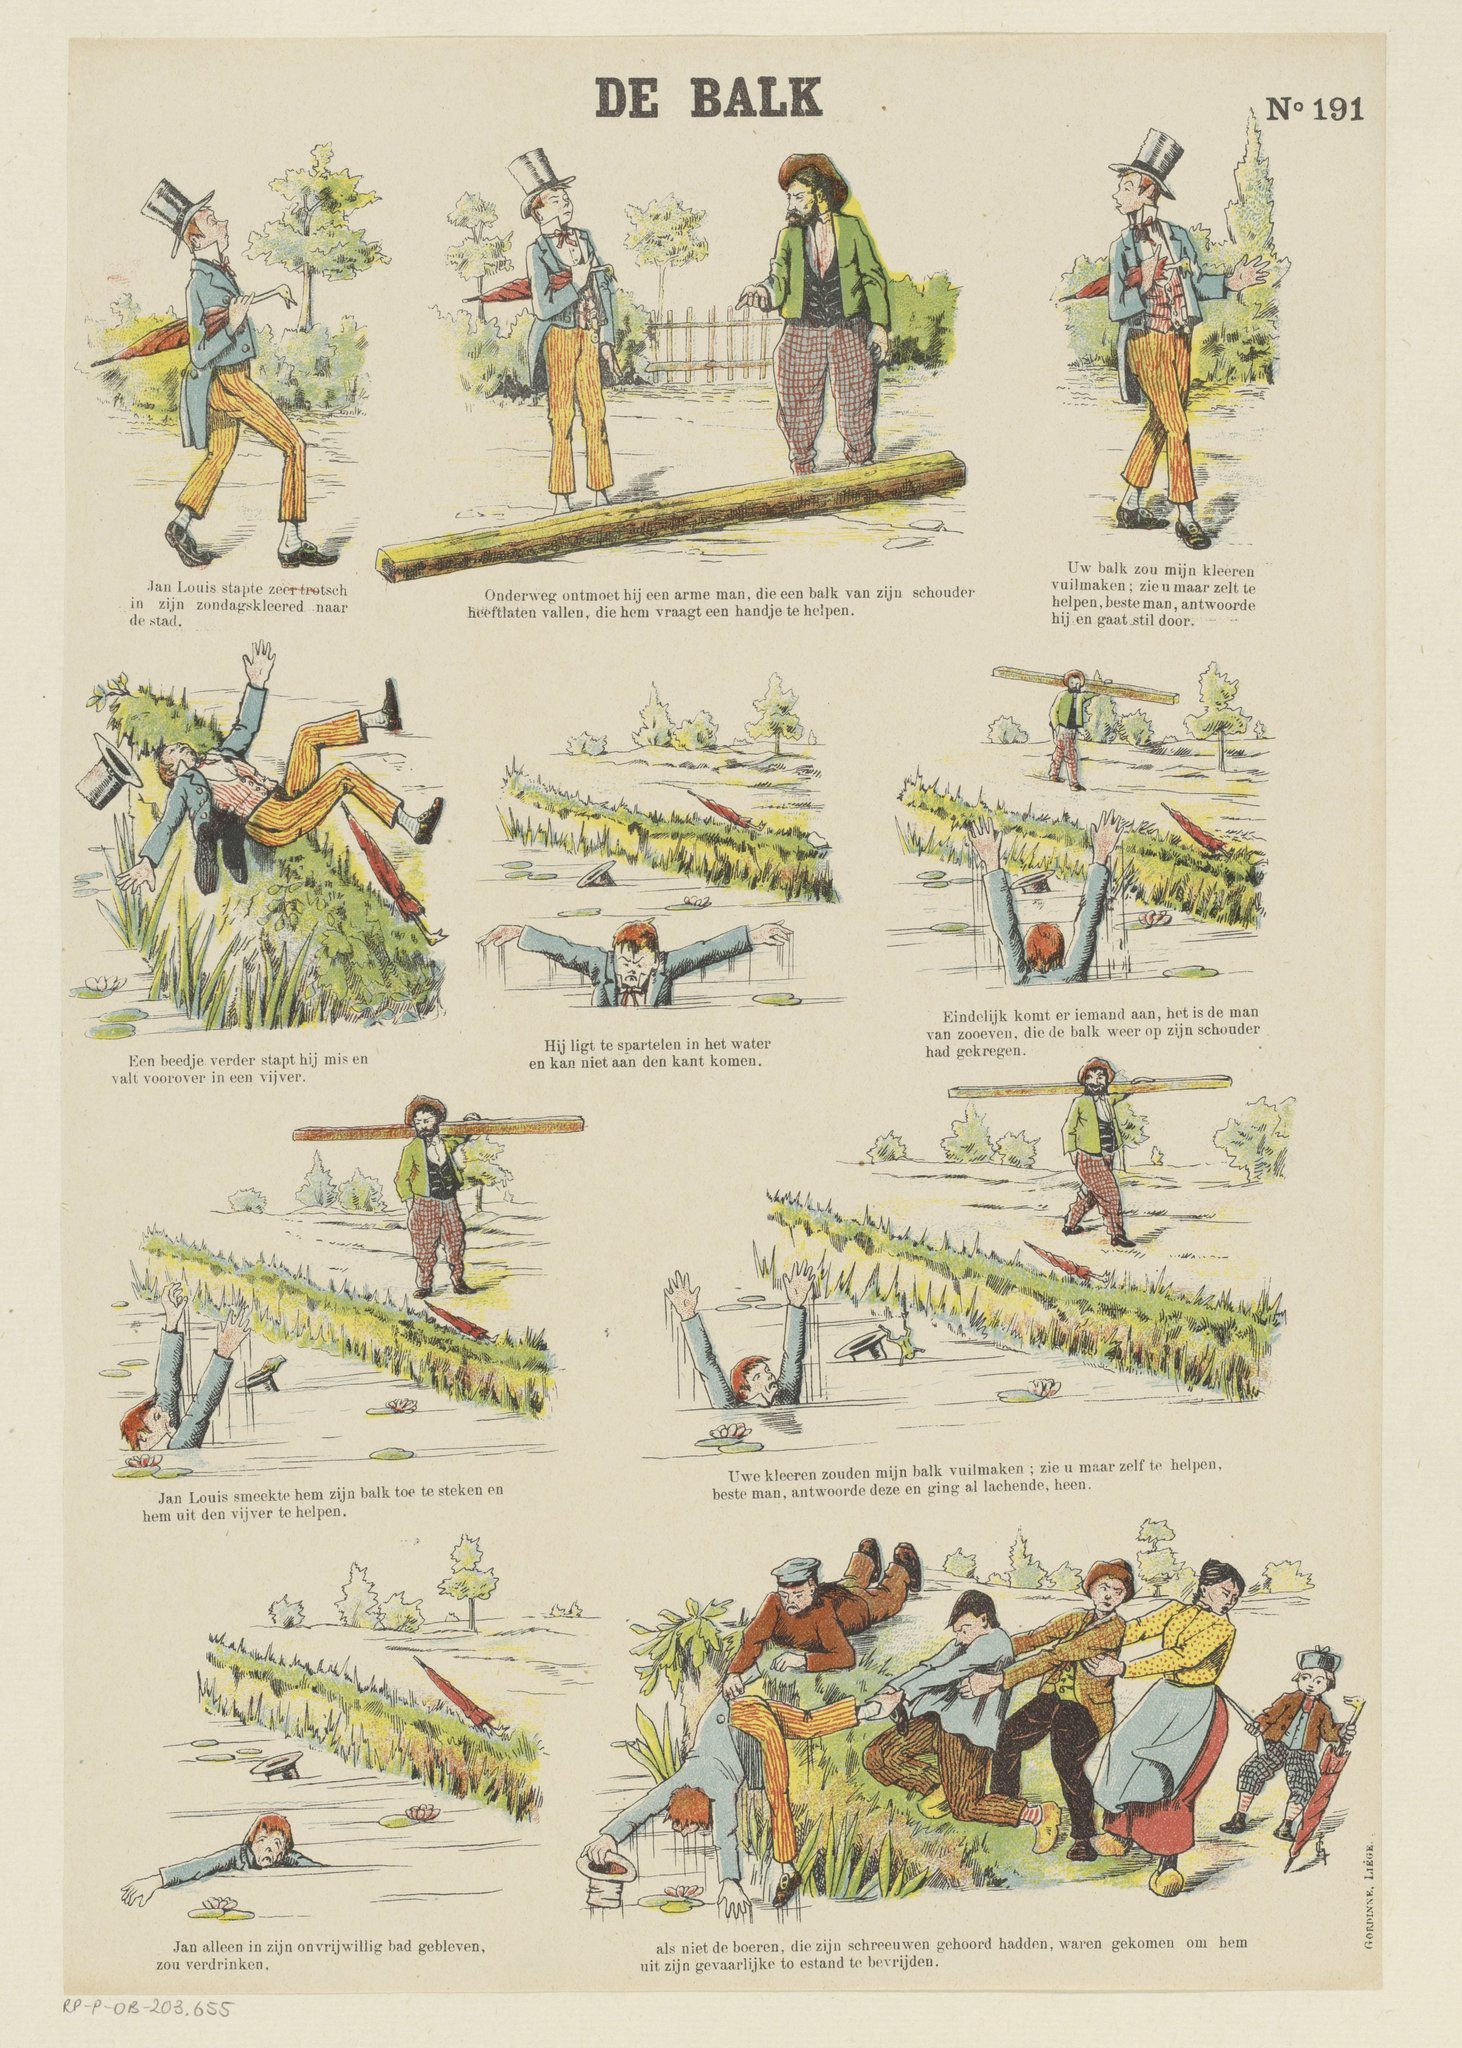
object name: popular print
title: De balk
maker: monogrammist jgr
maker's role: print maker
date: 1894-1959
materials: paper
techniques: lithograph, letterpress printing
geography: liège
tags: contrast between rich and poor, saving a person from drowning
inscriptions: collector's mark: Lugt 2760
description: Blad met 10 voorstellingen over Jan Louis die in een vijver valt. Onder elke afbeelding een onderschrift. Genummerd rechtsboven: No 191.